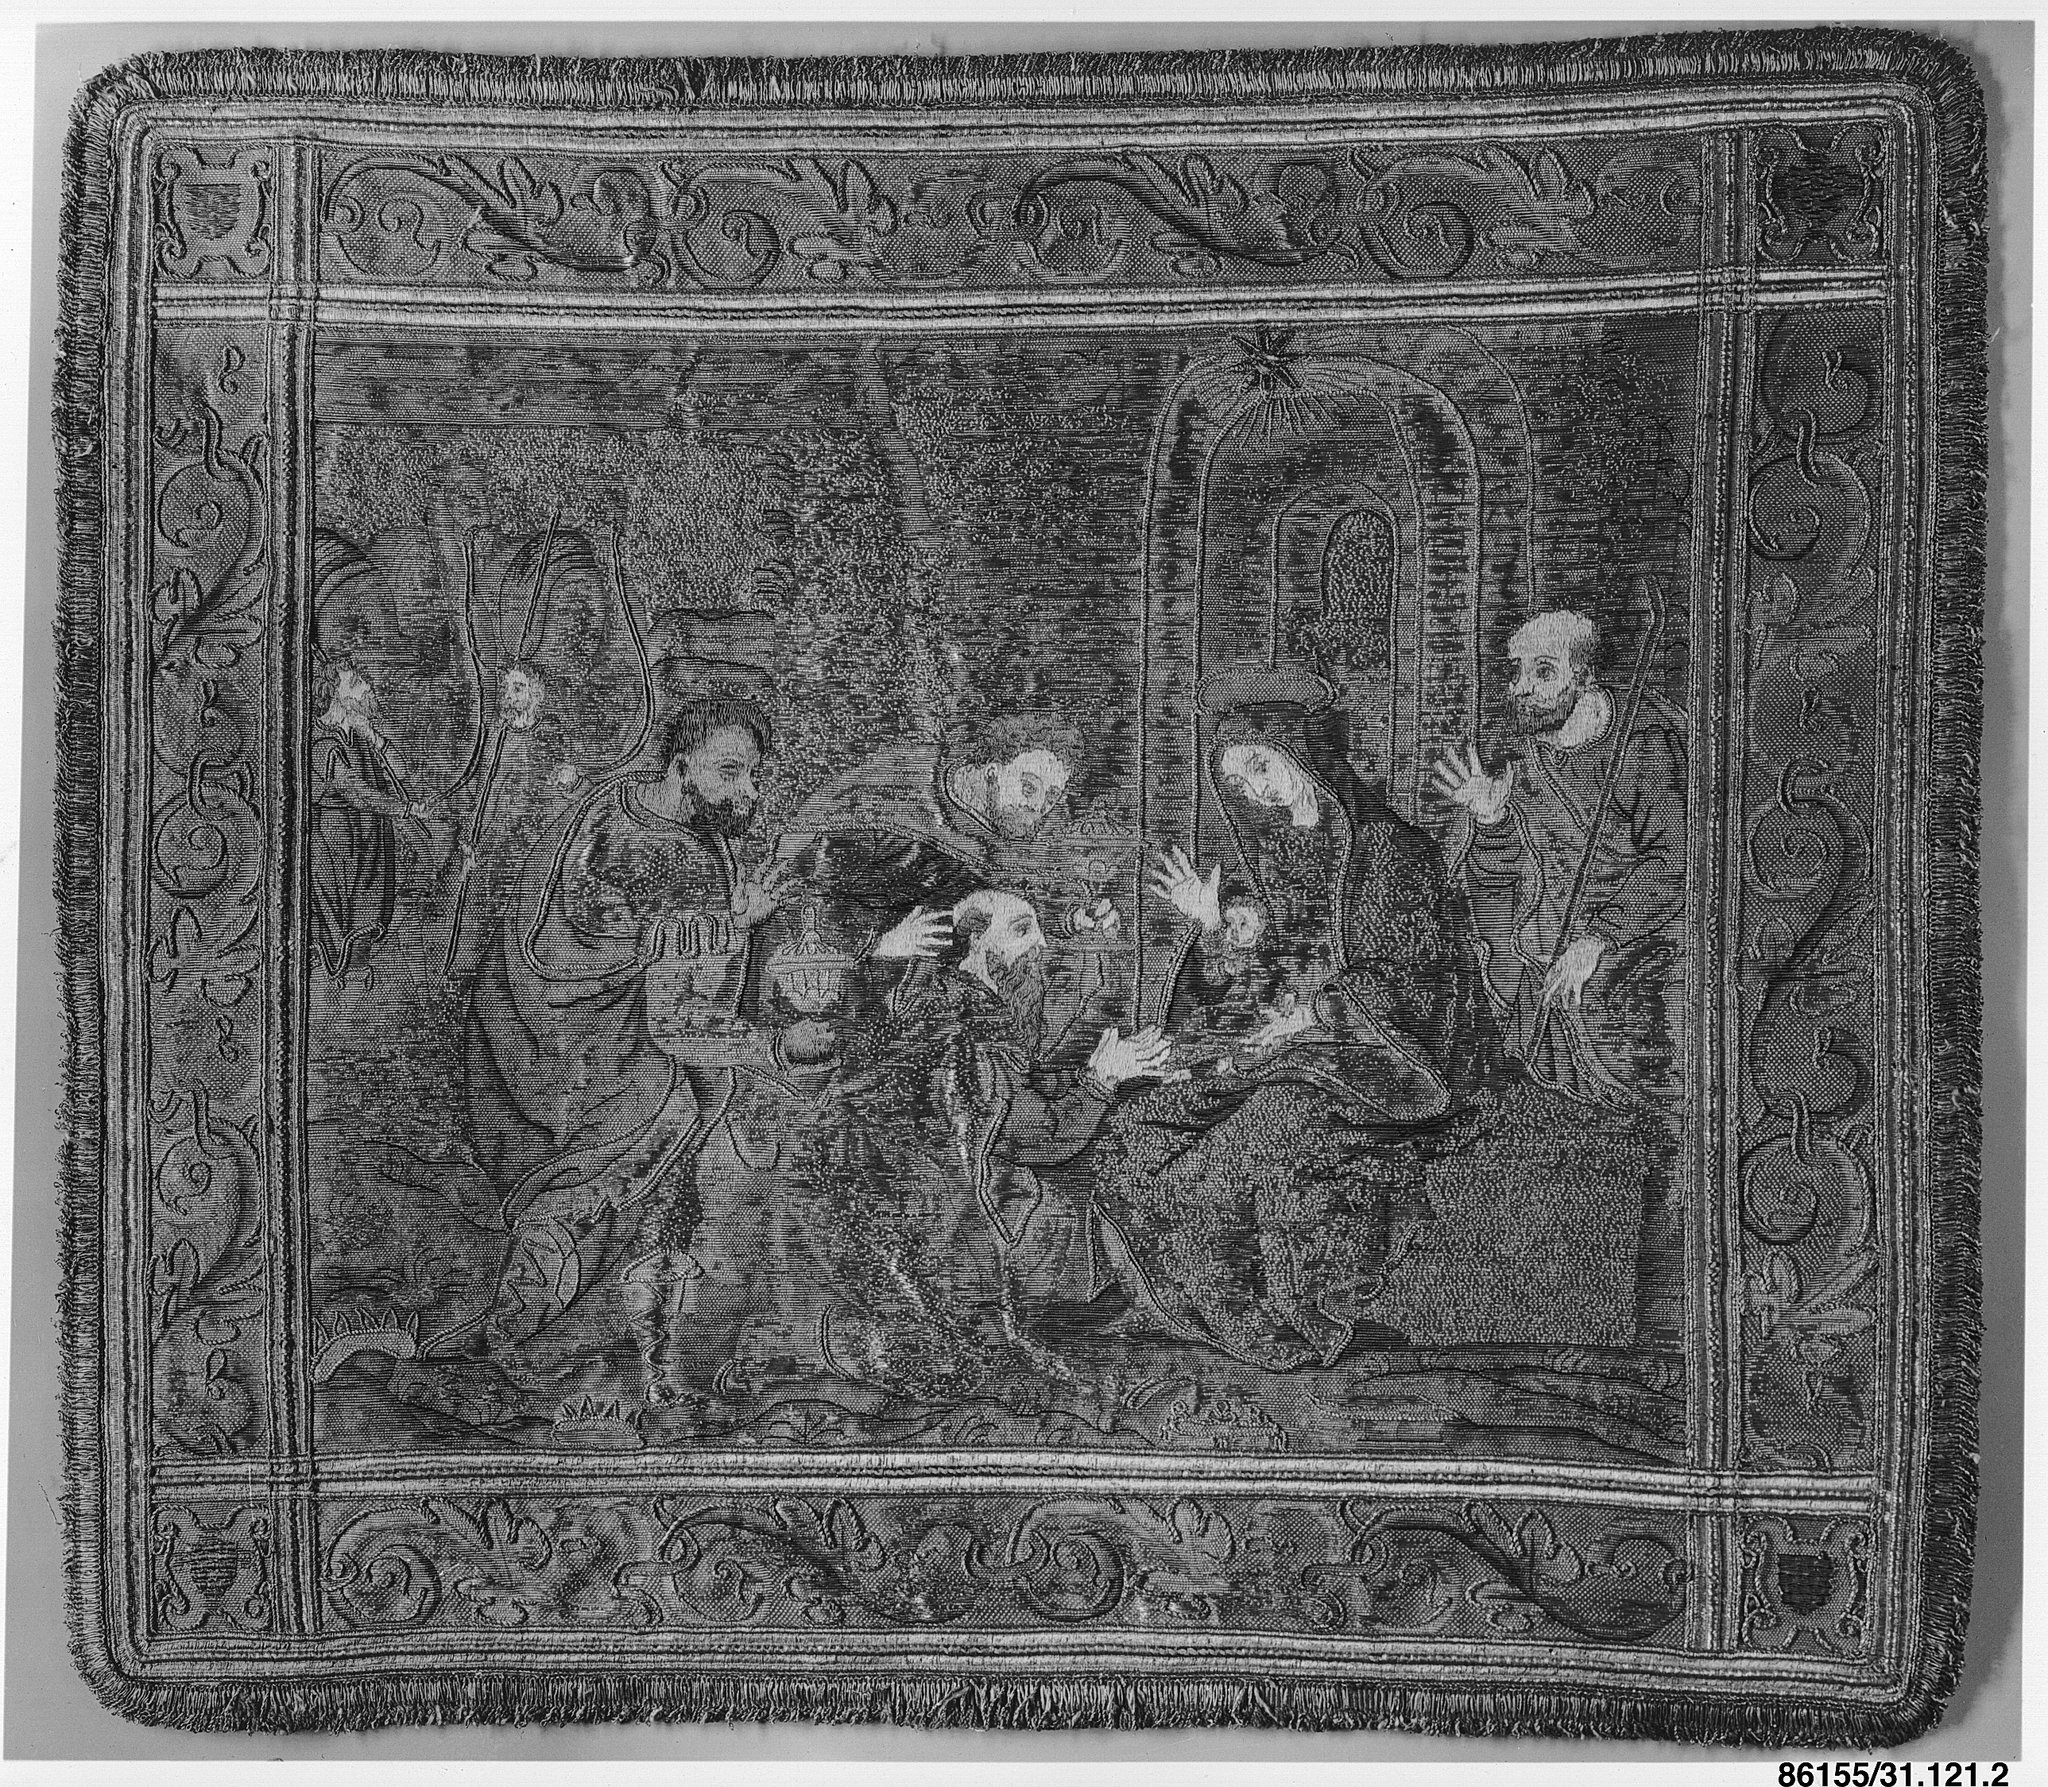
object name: panel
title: The Adoration of the Magi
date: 1501-1533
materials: linen, metal thread, silk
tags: adoration of the magi